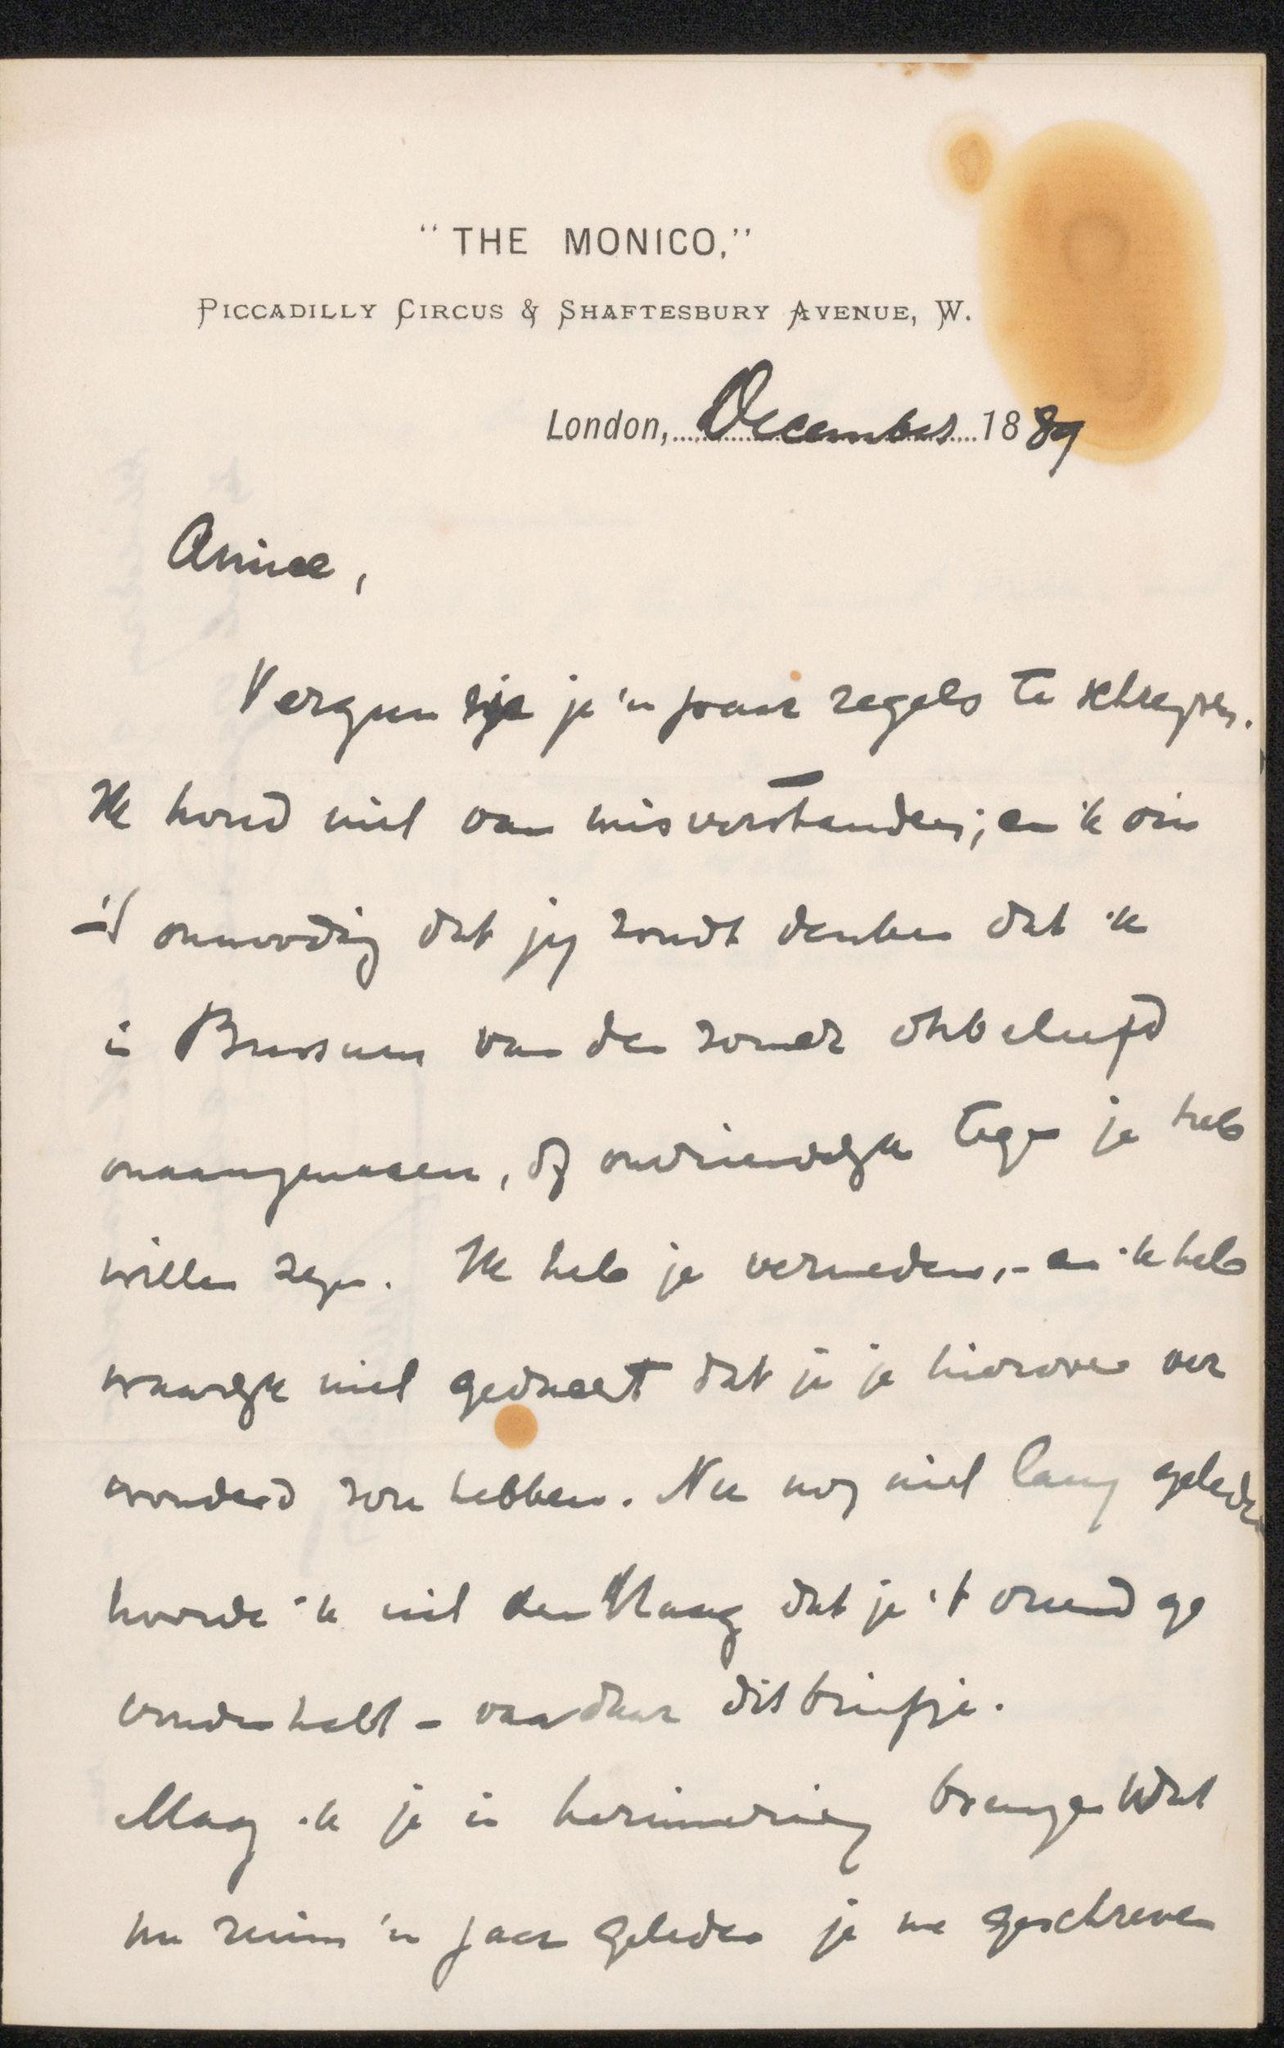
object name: letter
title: Brief aan Jan Veth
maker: willem witsen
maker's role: draughtsman, painter, print maker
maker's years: 1860-1923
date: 1812-1889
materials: ink, paper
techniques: pen, printing, writing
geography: london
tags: dordrecht, painter, print maker, draughtsman, designer, jan veth, marseille, sculptor, henri de groux, the hague, willem kloos, criticizing and discussing art, art criticism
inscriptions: collector's mark: ‘RPK’, watermark